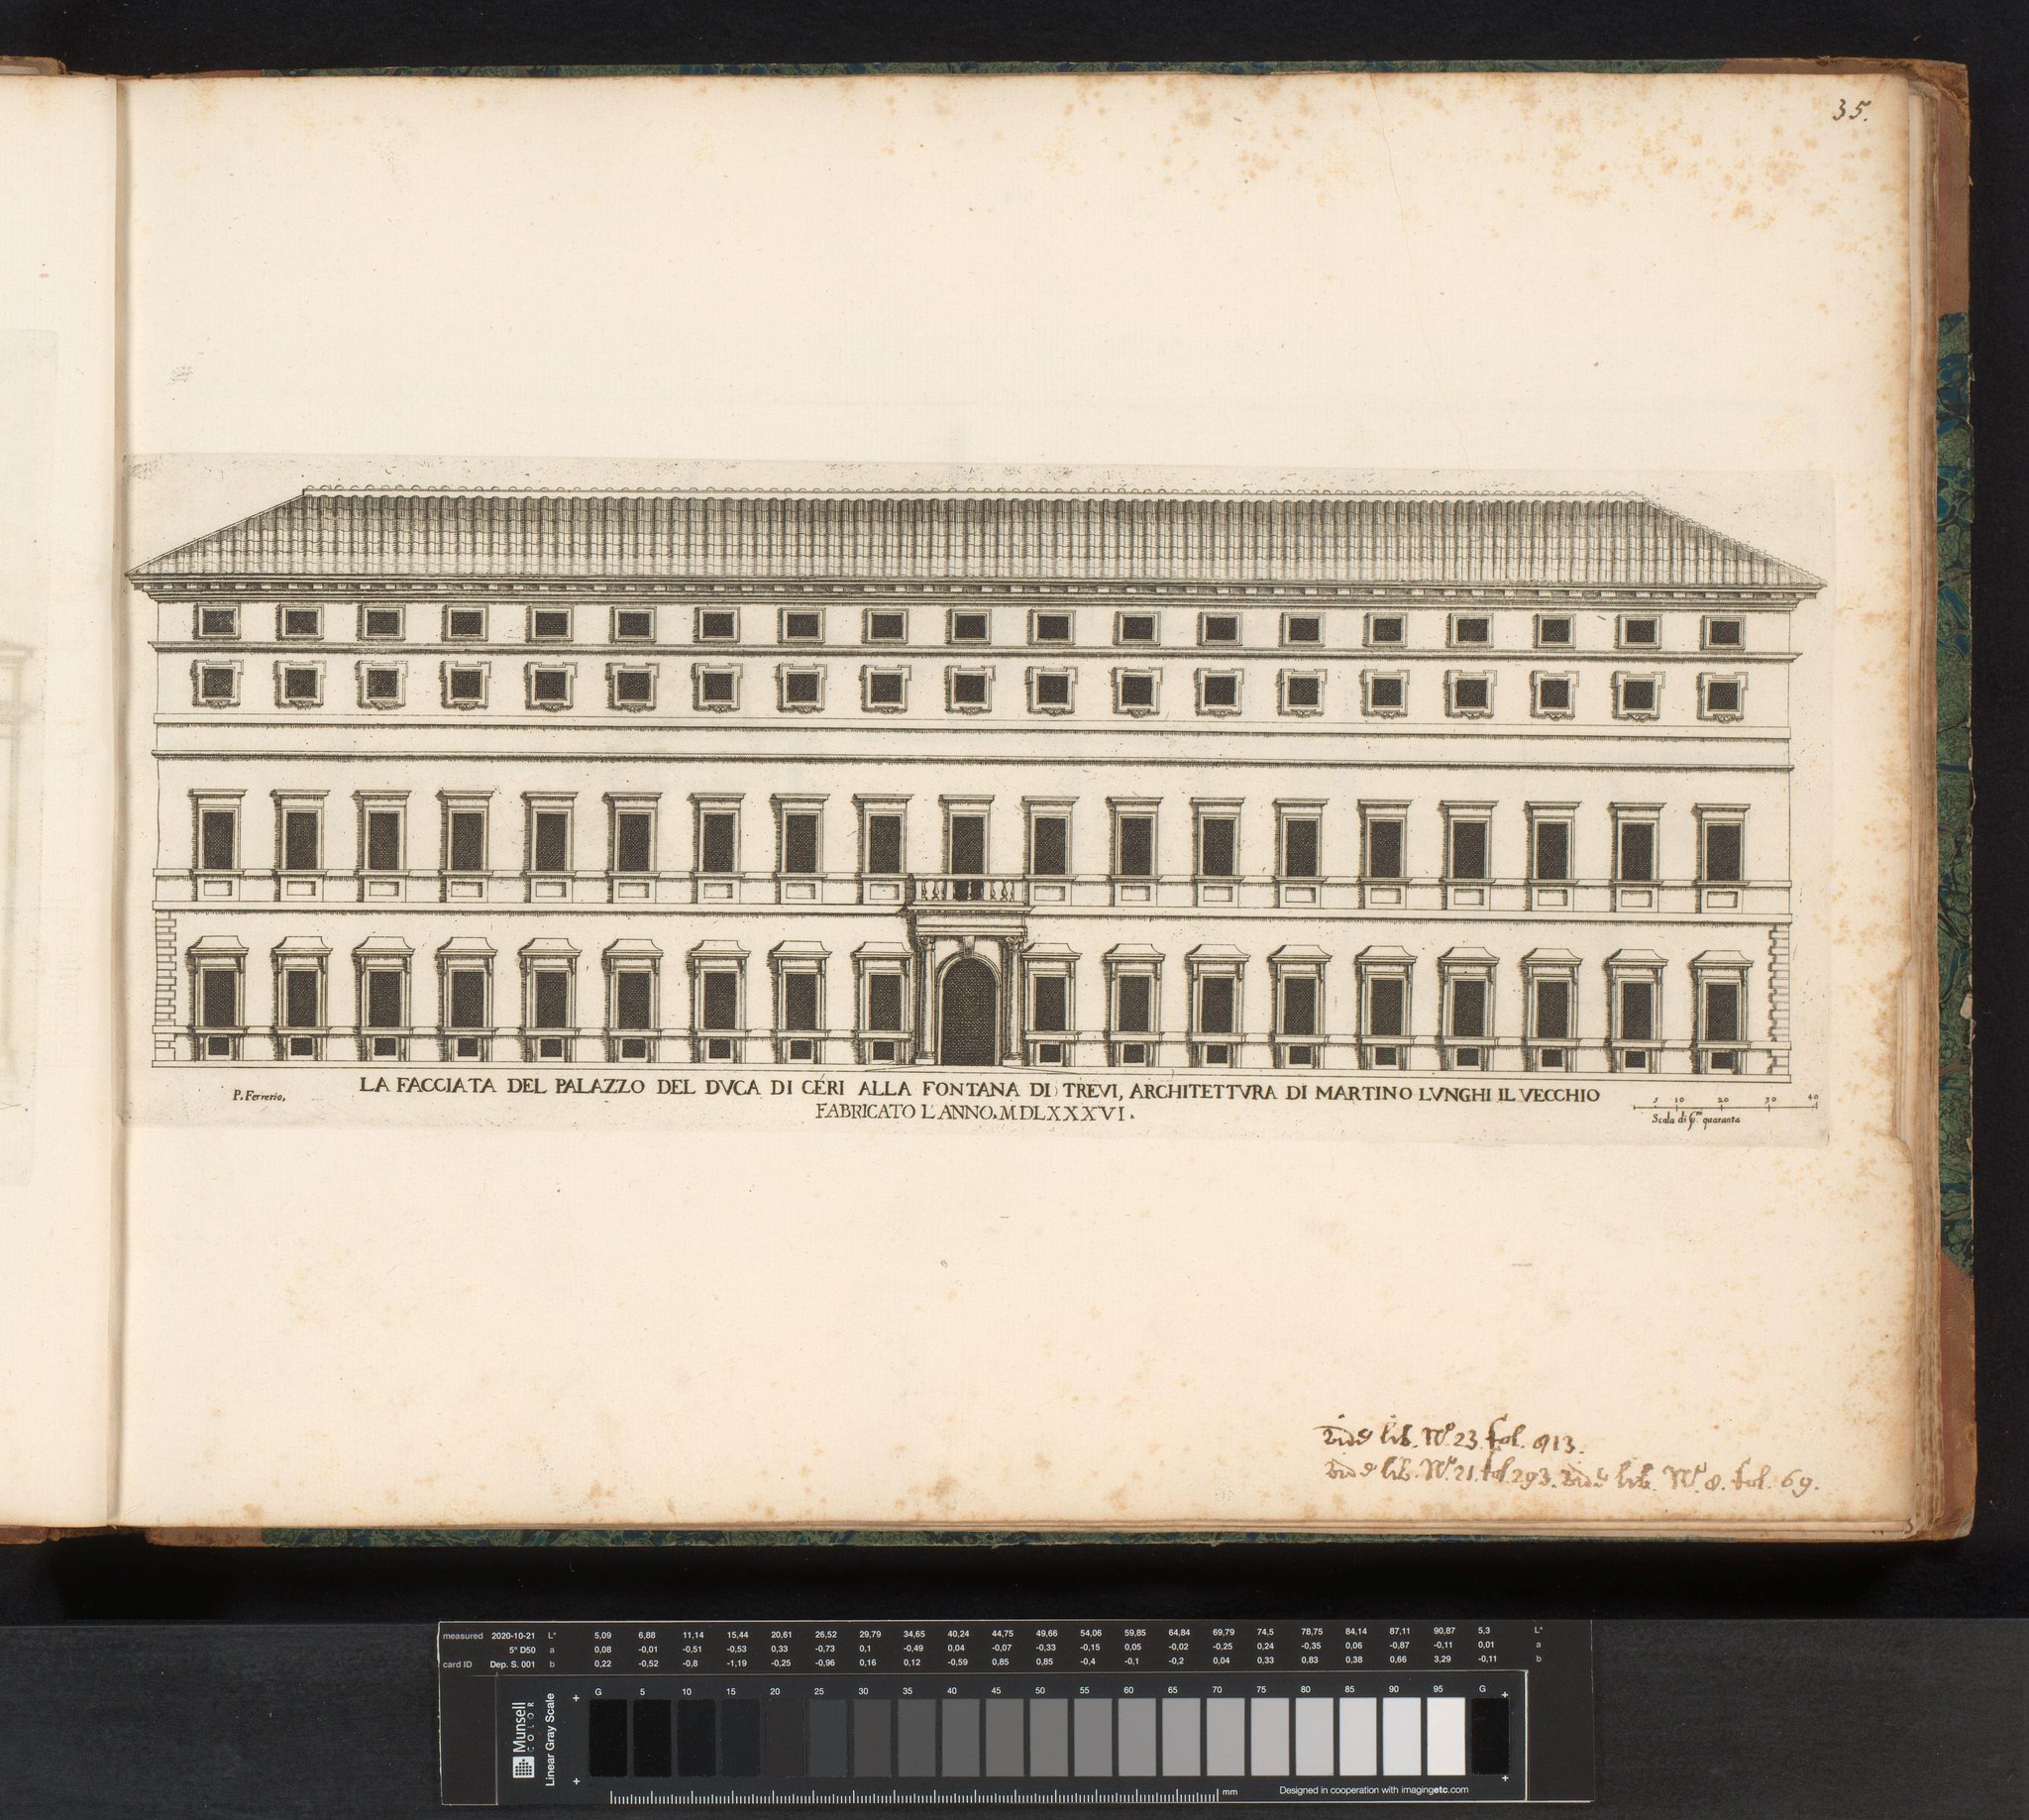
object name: print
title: Palazzi di Roma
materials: paper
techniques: etching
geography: italy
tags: palace, façade (of house or building), rome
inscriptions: number: ‘35’, inscription: ‘Ende lib. No. 23. fol. 813./ Ende lib. No. 21 fol. 293. Ende lib. No. 8. fol. 69.’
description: Deze prent maakt deel uit van de reeks getiteld: Palazzi di Roma. Deze reeks bestaat uit twee boeken. Boek één getiteld: Palazzi di Roma dei più celebri architetti..., bestaat uit 44 prenten die worden toegeschreven aan Giovanni Battista Falda (naam staat enkel op prent 27) en uitgegeven door Giovanni Giacomo de'Rossi. Deze 44 prenten zijn bekend in twee staten (met en zonder nummer). Boek twee getiteld: Nuovi disegni dell'architetture... libro secondo, bevat 66 prenten door Giovanni Battista Falda en Simone Felice. Deze 66 prenten zijn bekend in twee staten (met en zonder nummer).